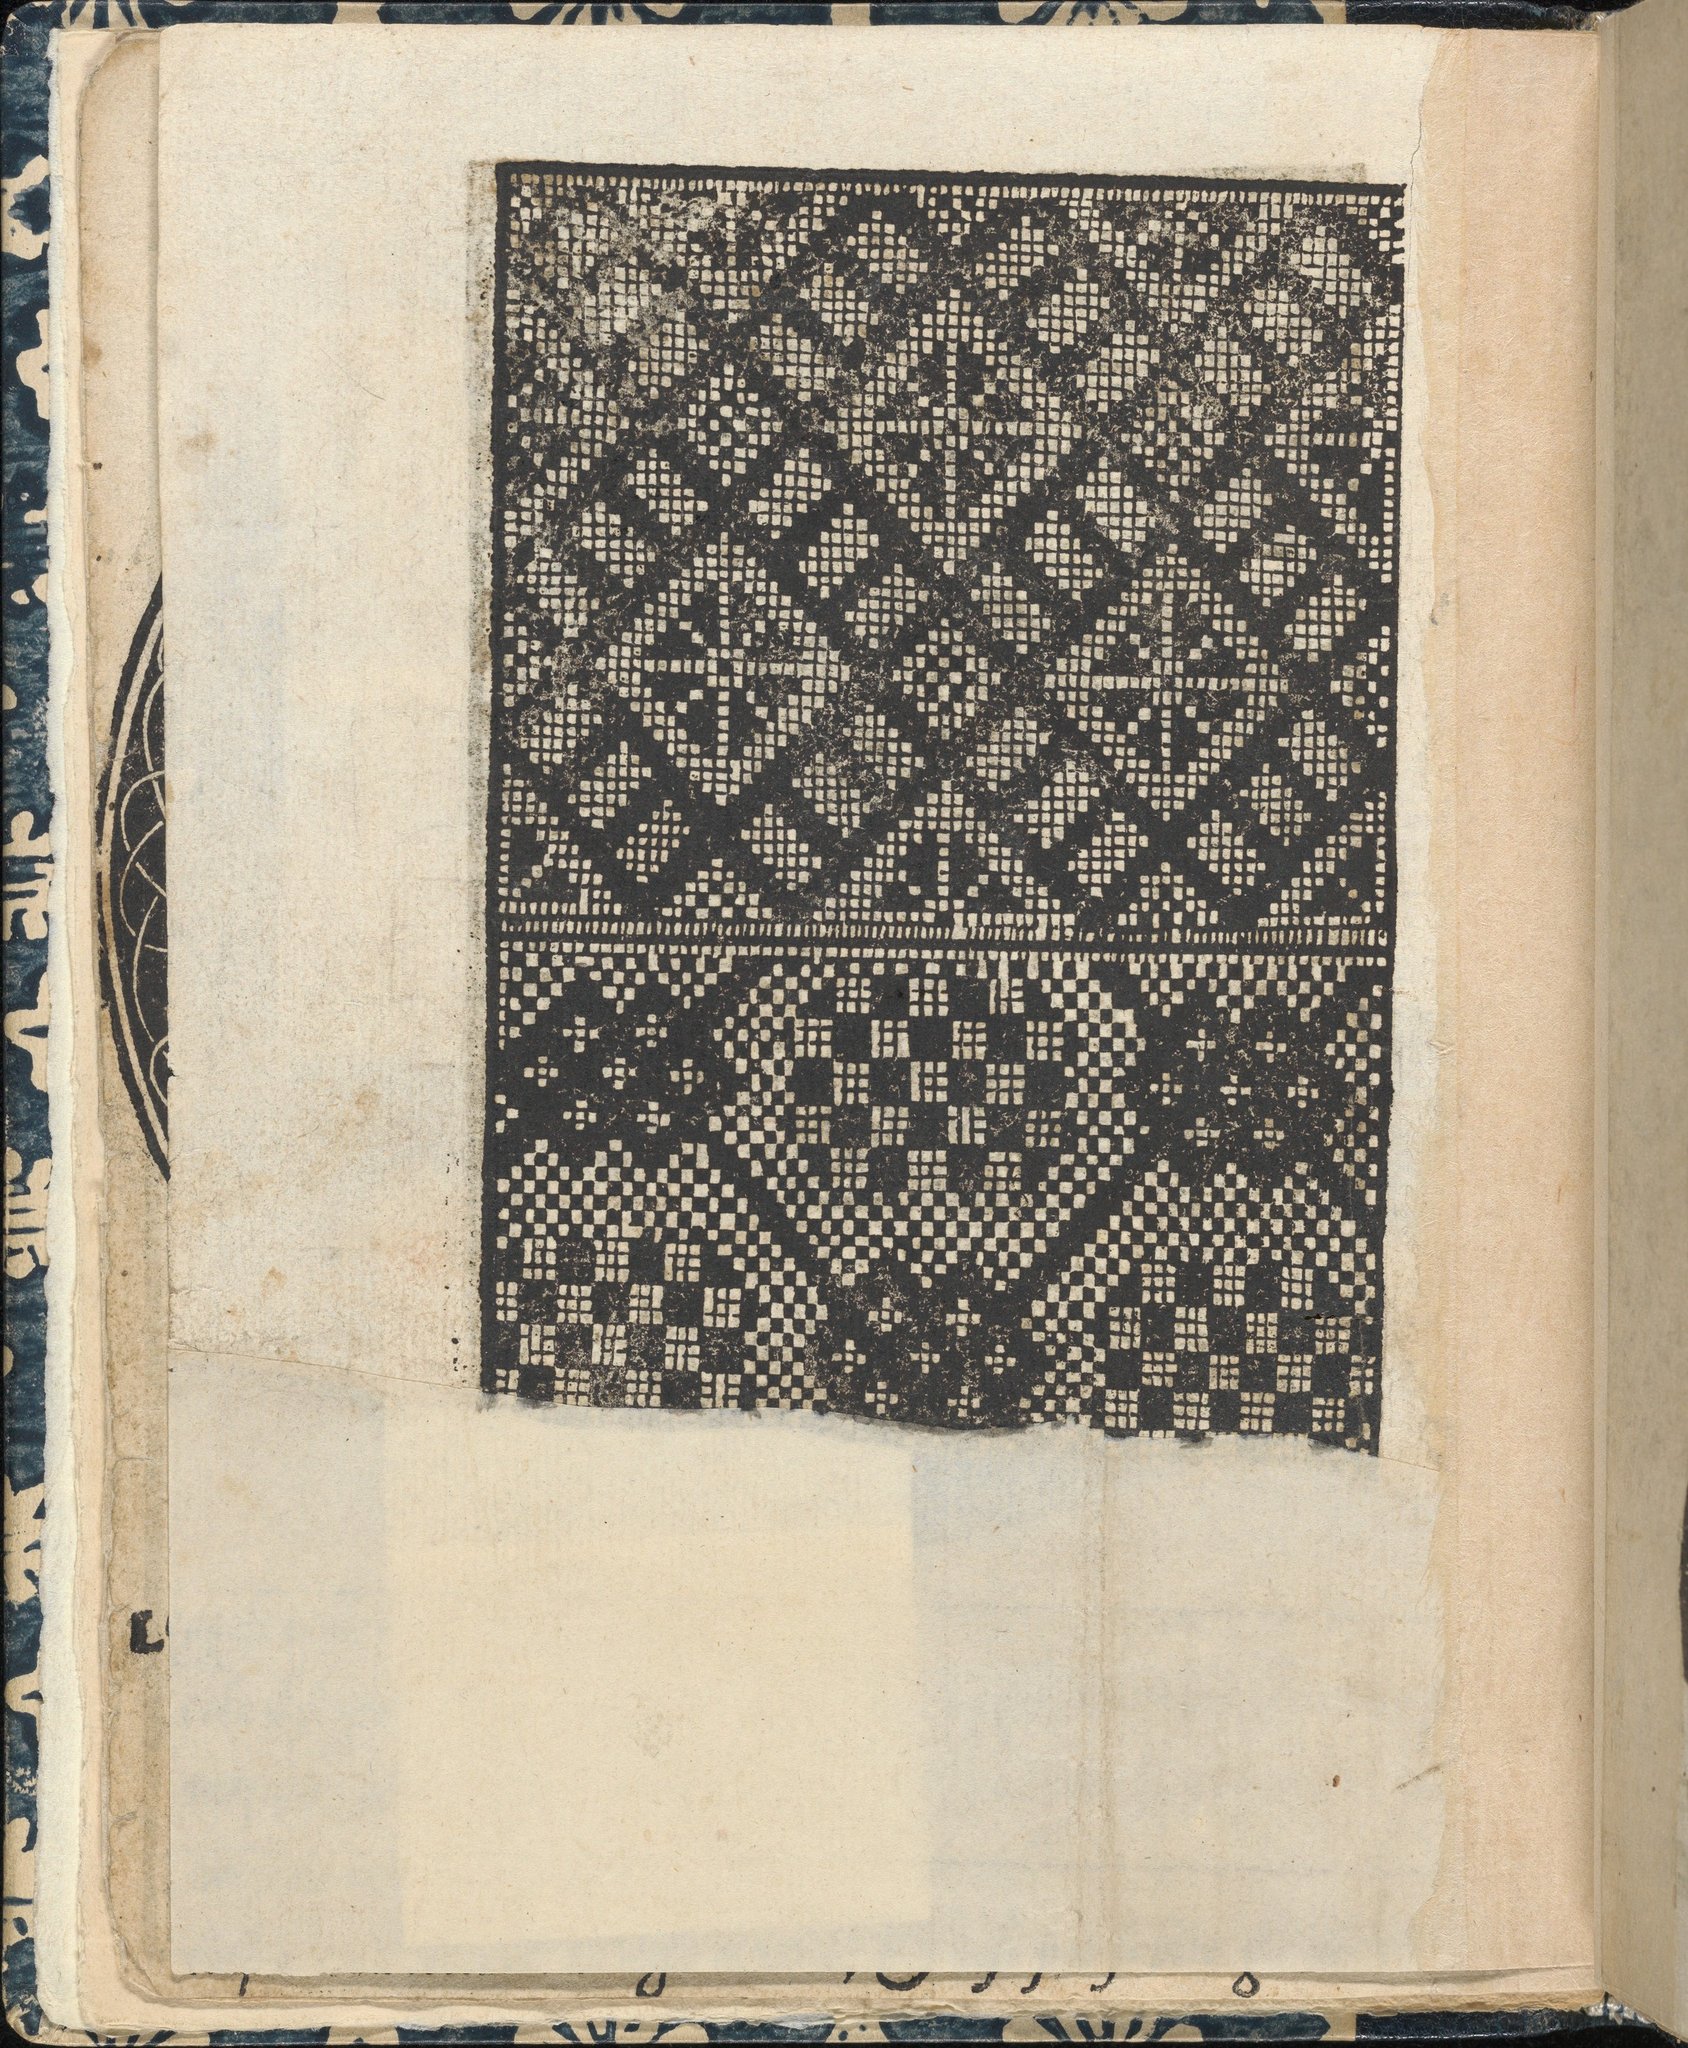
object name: book print ornament architecture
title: Essempio di recammi, page 5 (verso)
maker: giovanni antonio tagliente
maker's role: author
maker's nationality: italian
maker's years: 1465-1528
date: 1530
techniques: woodcut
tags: ornament